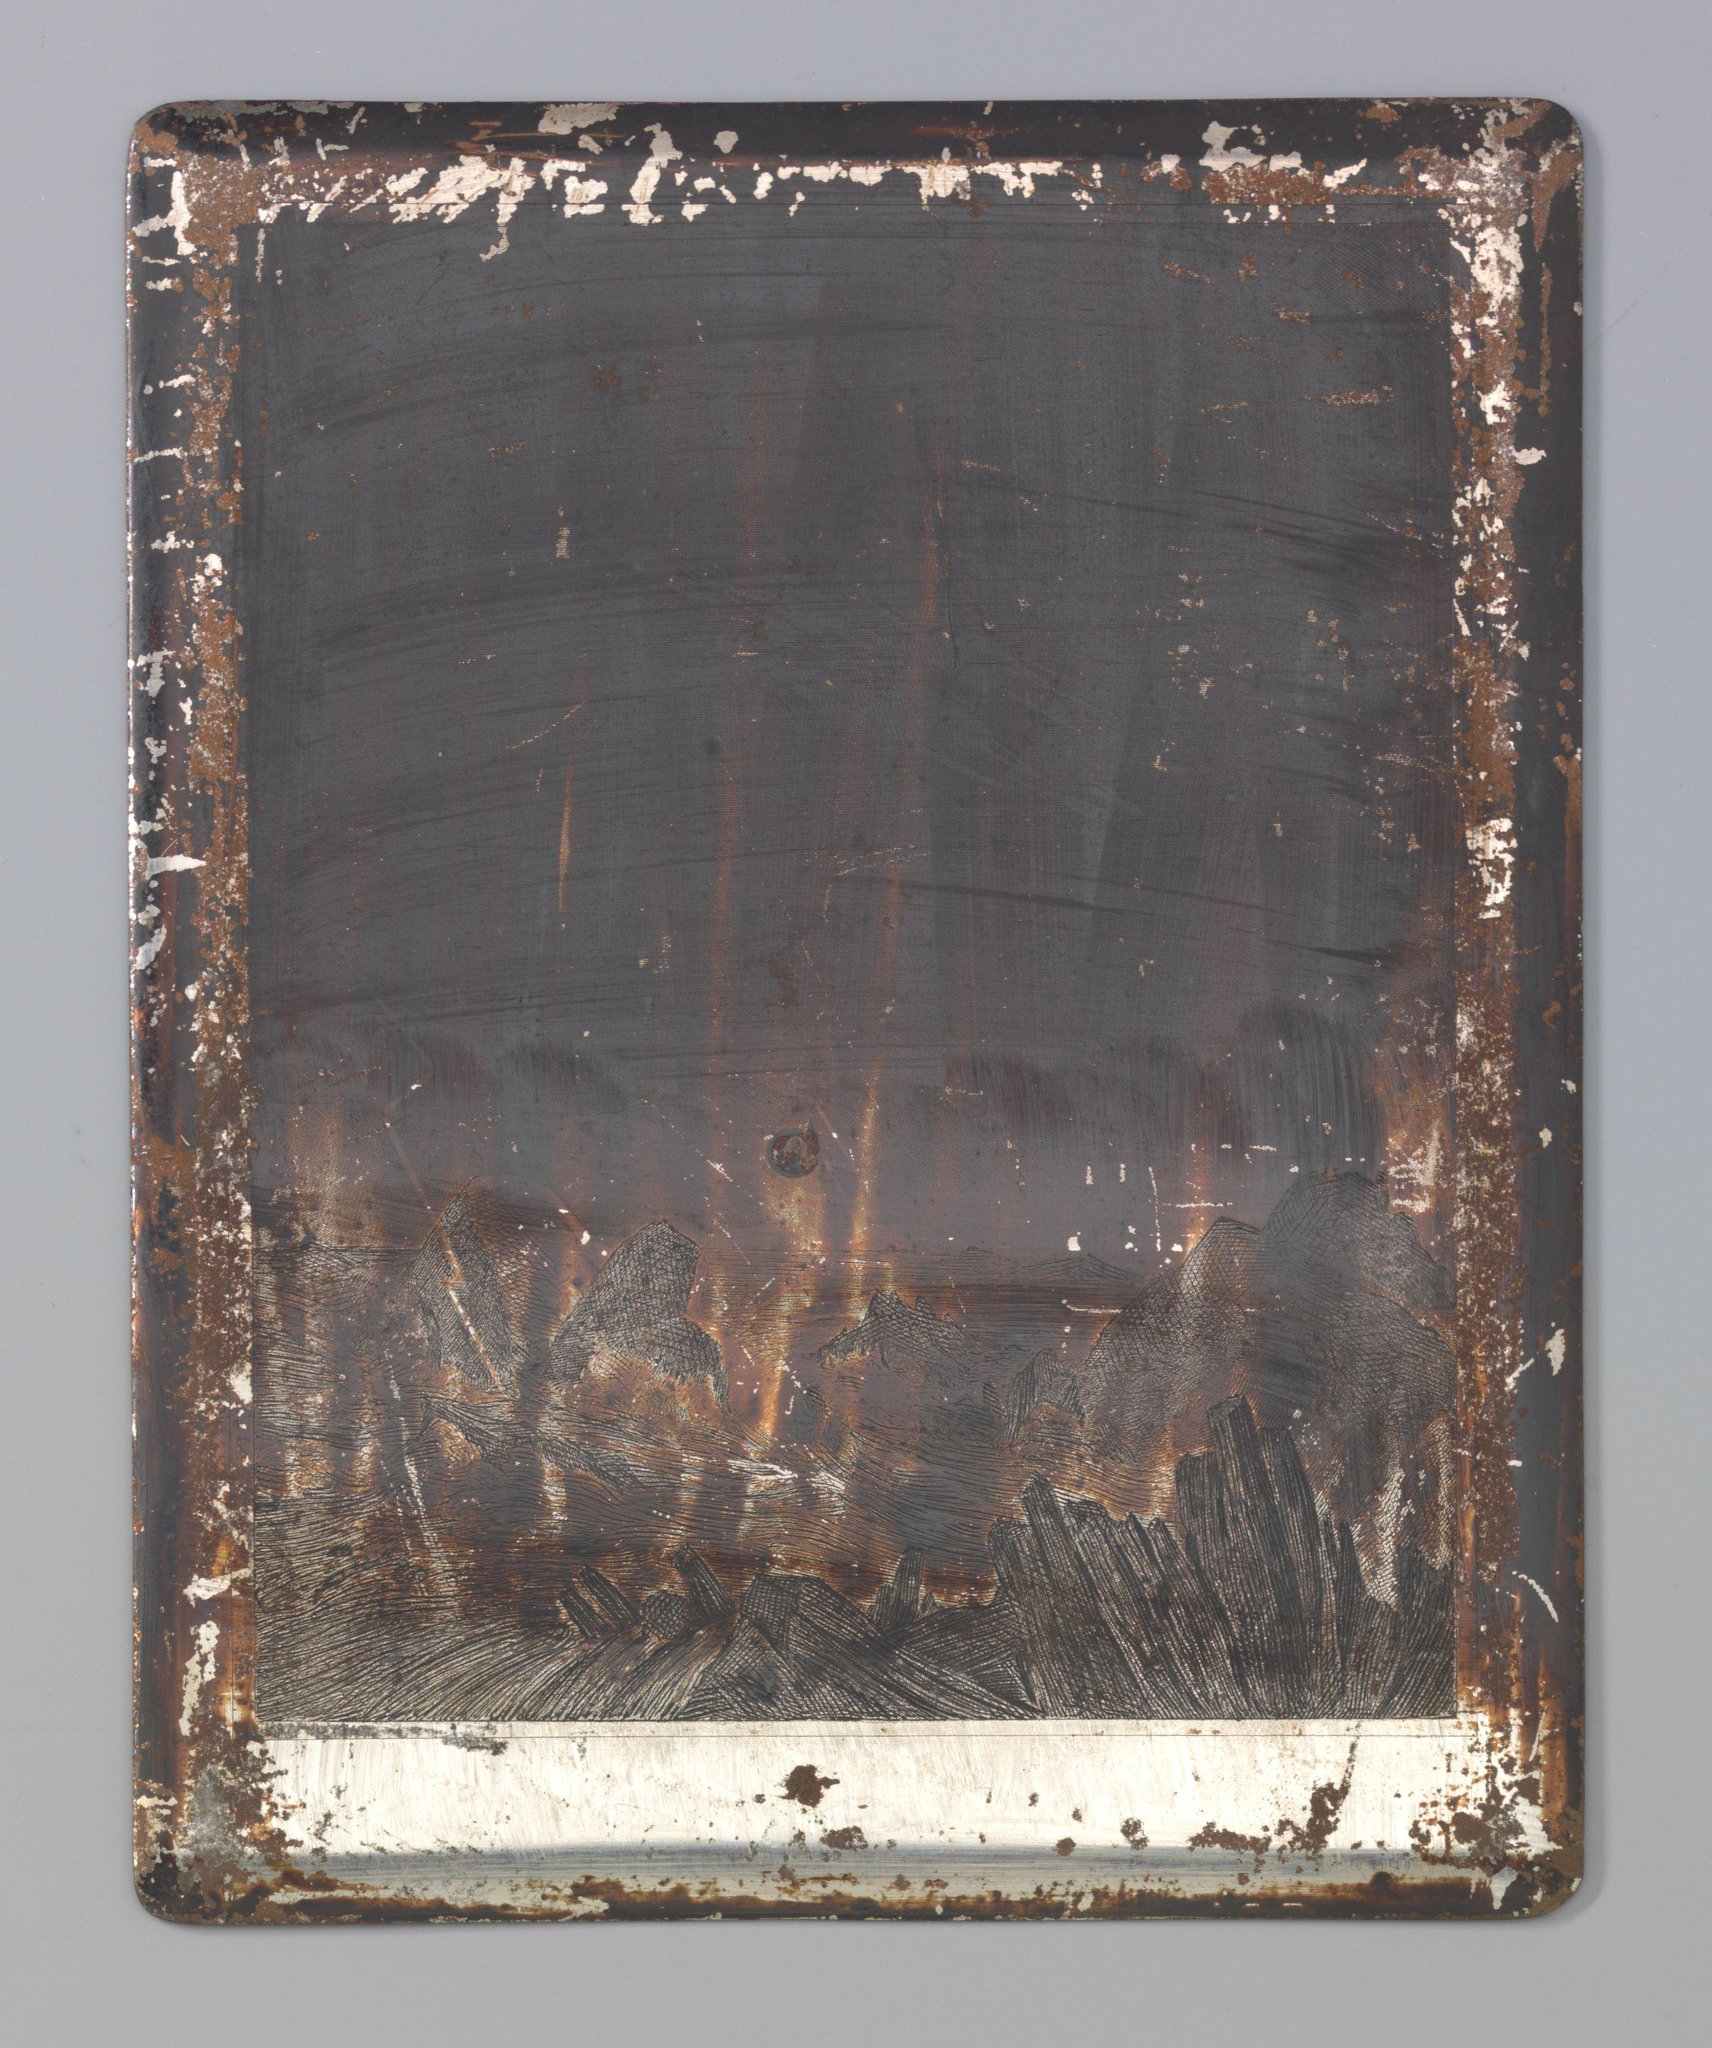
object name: staalplaat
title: Rotsblokken in zee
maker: Anonymous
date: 1800-1899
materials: steel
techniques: etching